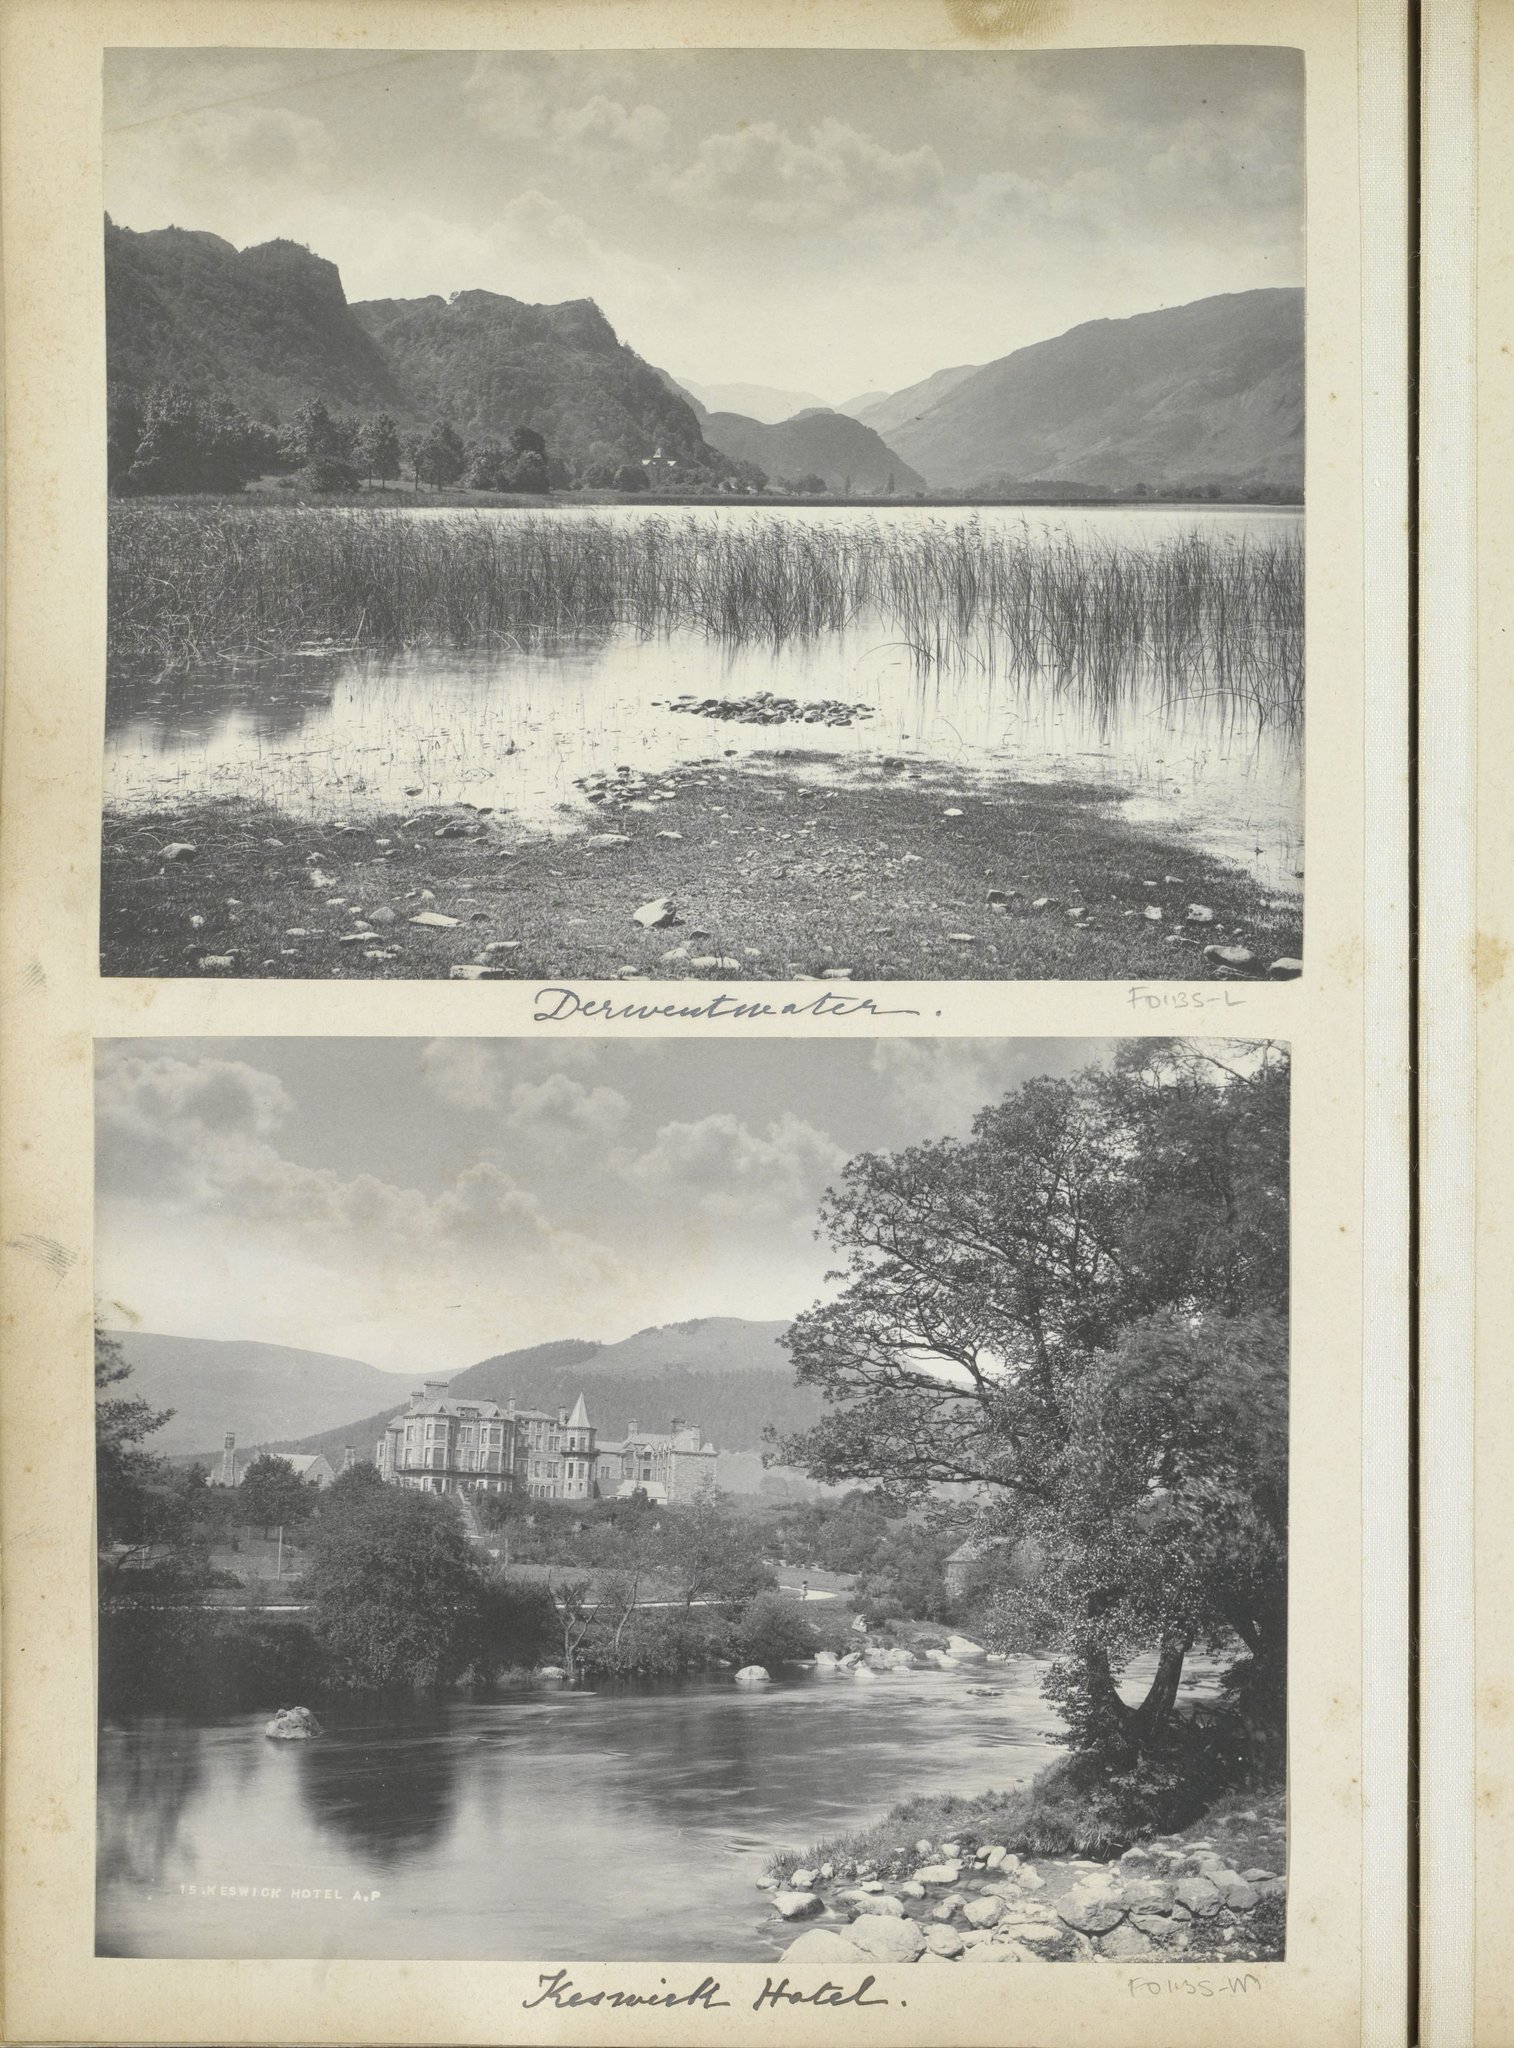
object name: album leaf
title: Keswick Hotel A.P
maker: monogrammist ap (fotograaf)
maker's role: fotograaf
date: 1898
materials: paper, photographic support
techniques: platinum process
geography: keswick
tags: river (+ landscape with figures, staffage), hotel, hostelry, inn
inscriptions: number: ‘15’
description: Onderdeel van Reisalbum met foto's van bezienswaardigheden in Engeland en Frankrijk.